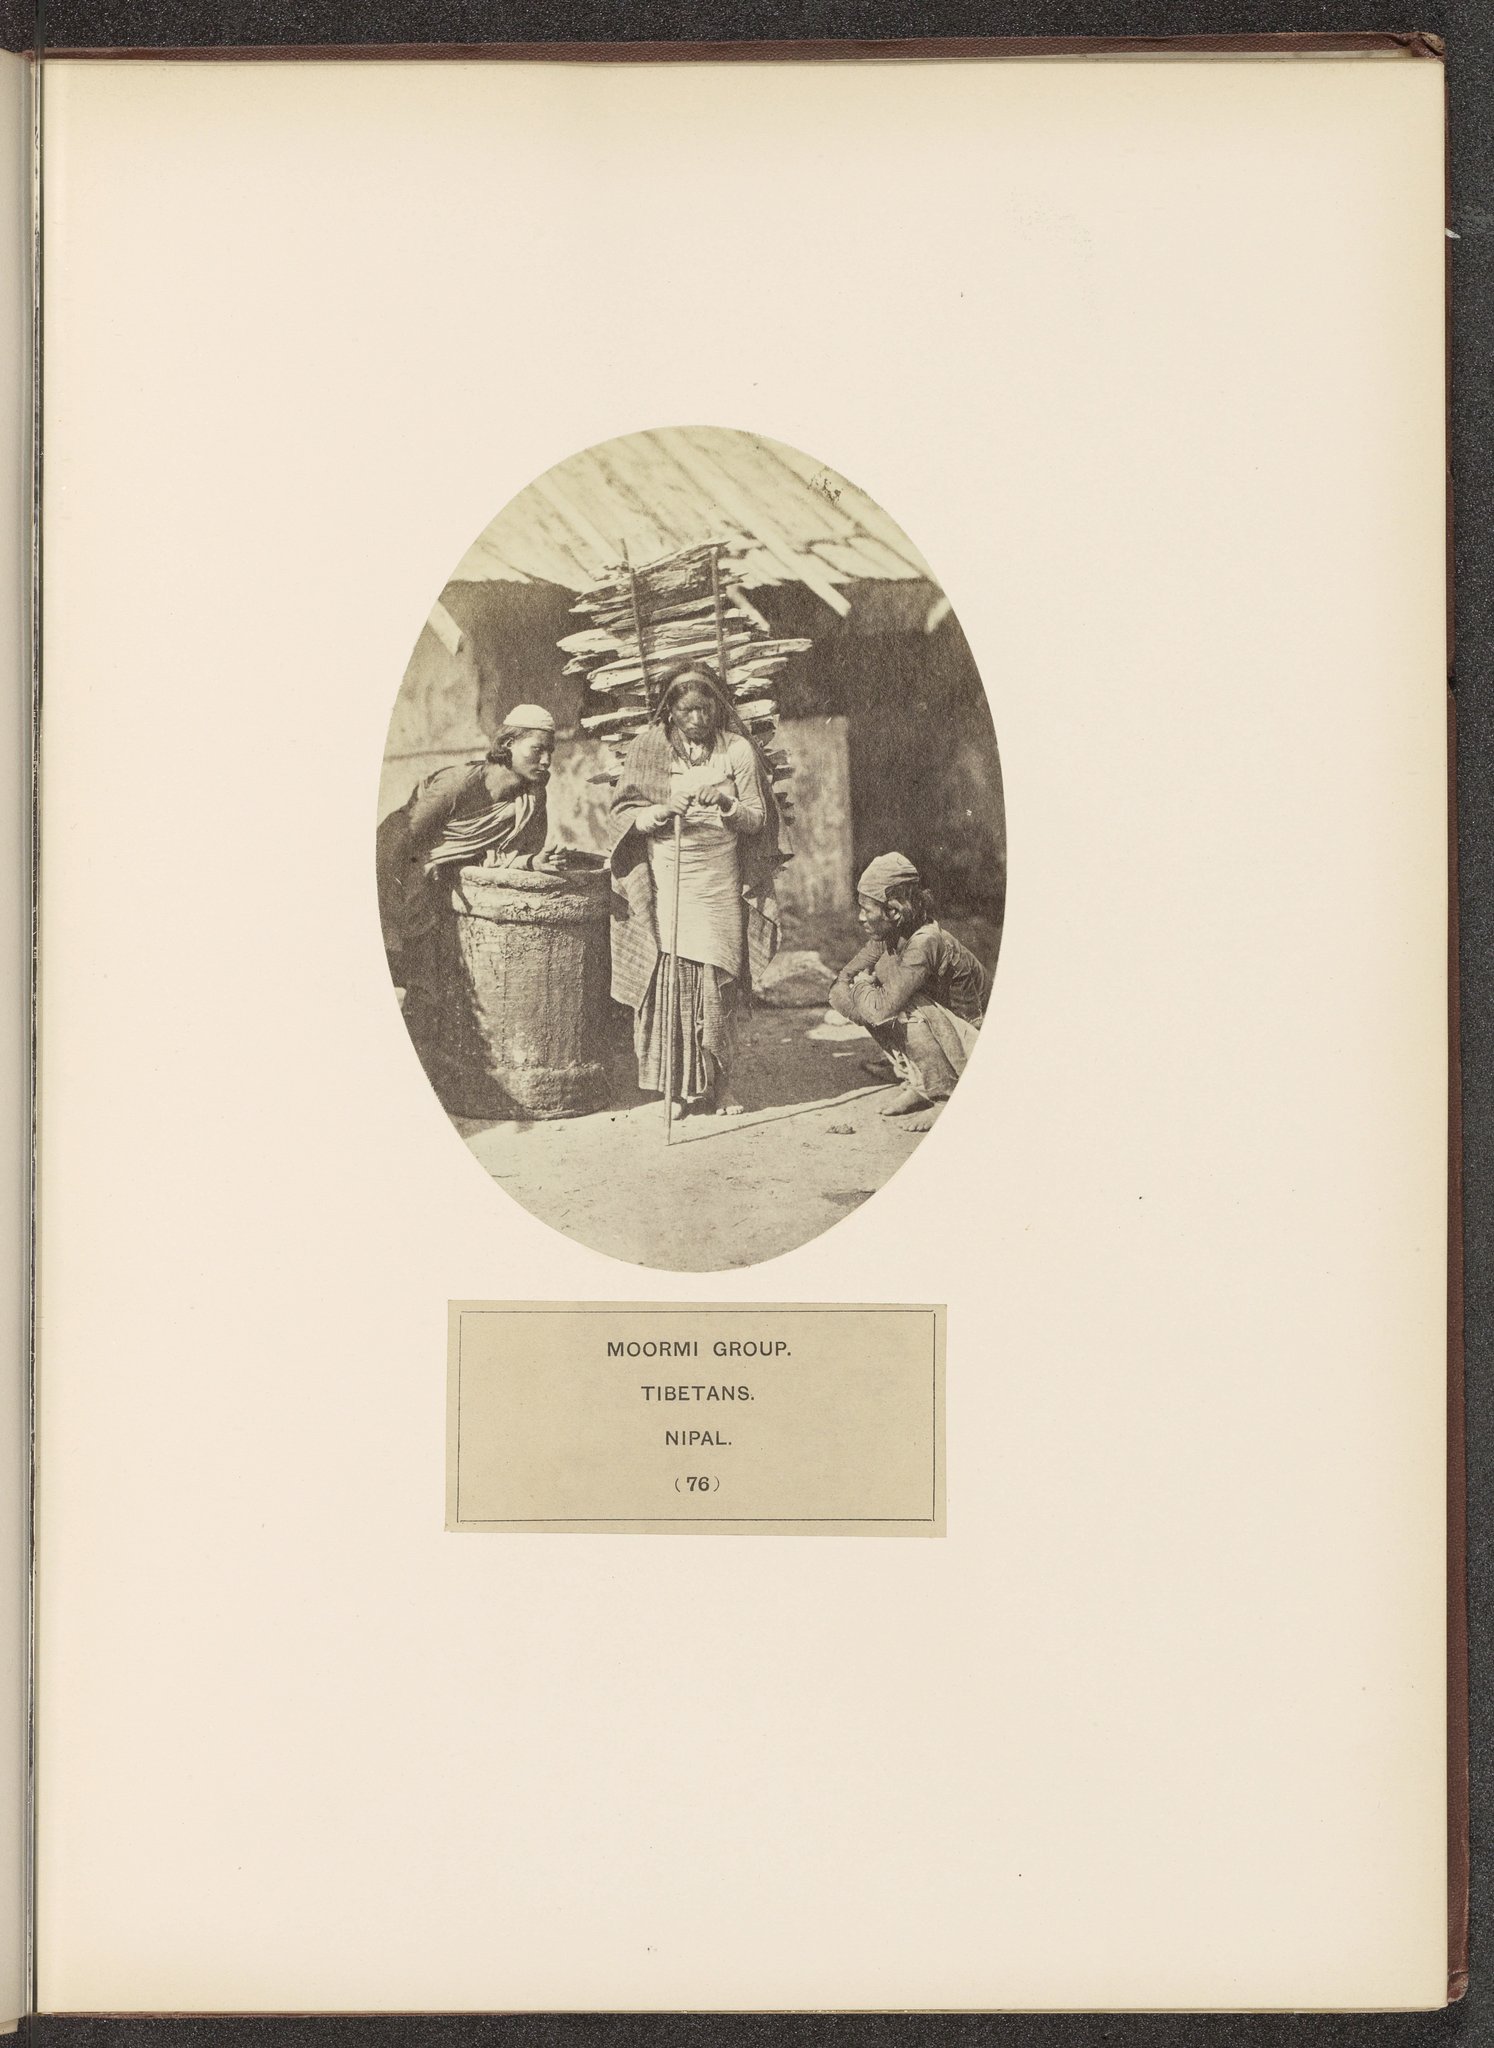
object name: page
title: Three people from the Moormi community of Nepal, in the middle a woman carrying wood on her back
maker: benjamin simpson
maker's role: fotograaf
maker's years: 1831-1923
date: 1858-1868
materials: photographic support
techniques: albumen print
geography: nepal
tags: human races; peoples; nationalities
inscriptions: number: ‘(76)’, inscription: ‘MOORMI GROUP./ TIBETANS./ NIPAL.’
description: De Moormi-gemeenschap is ook bekend als Tamang.